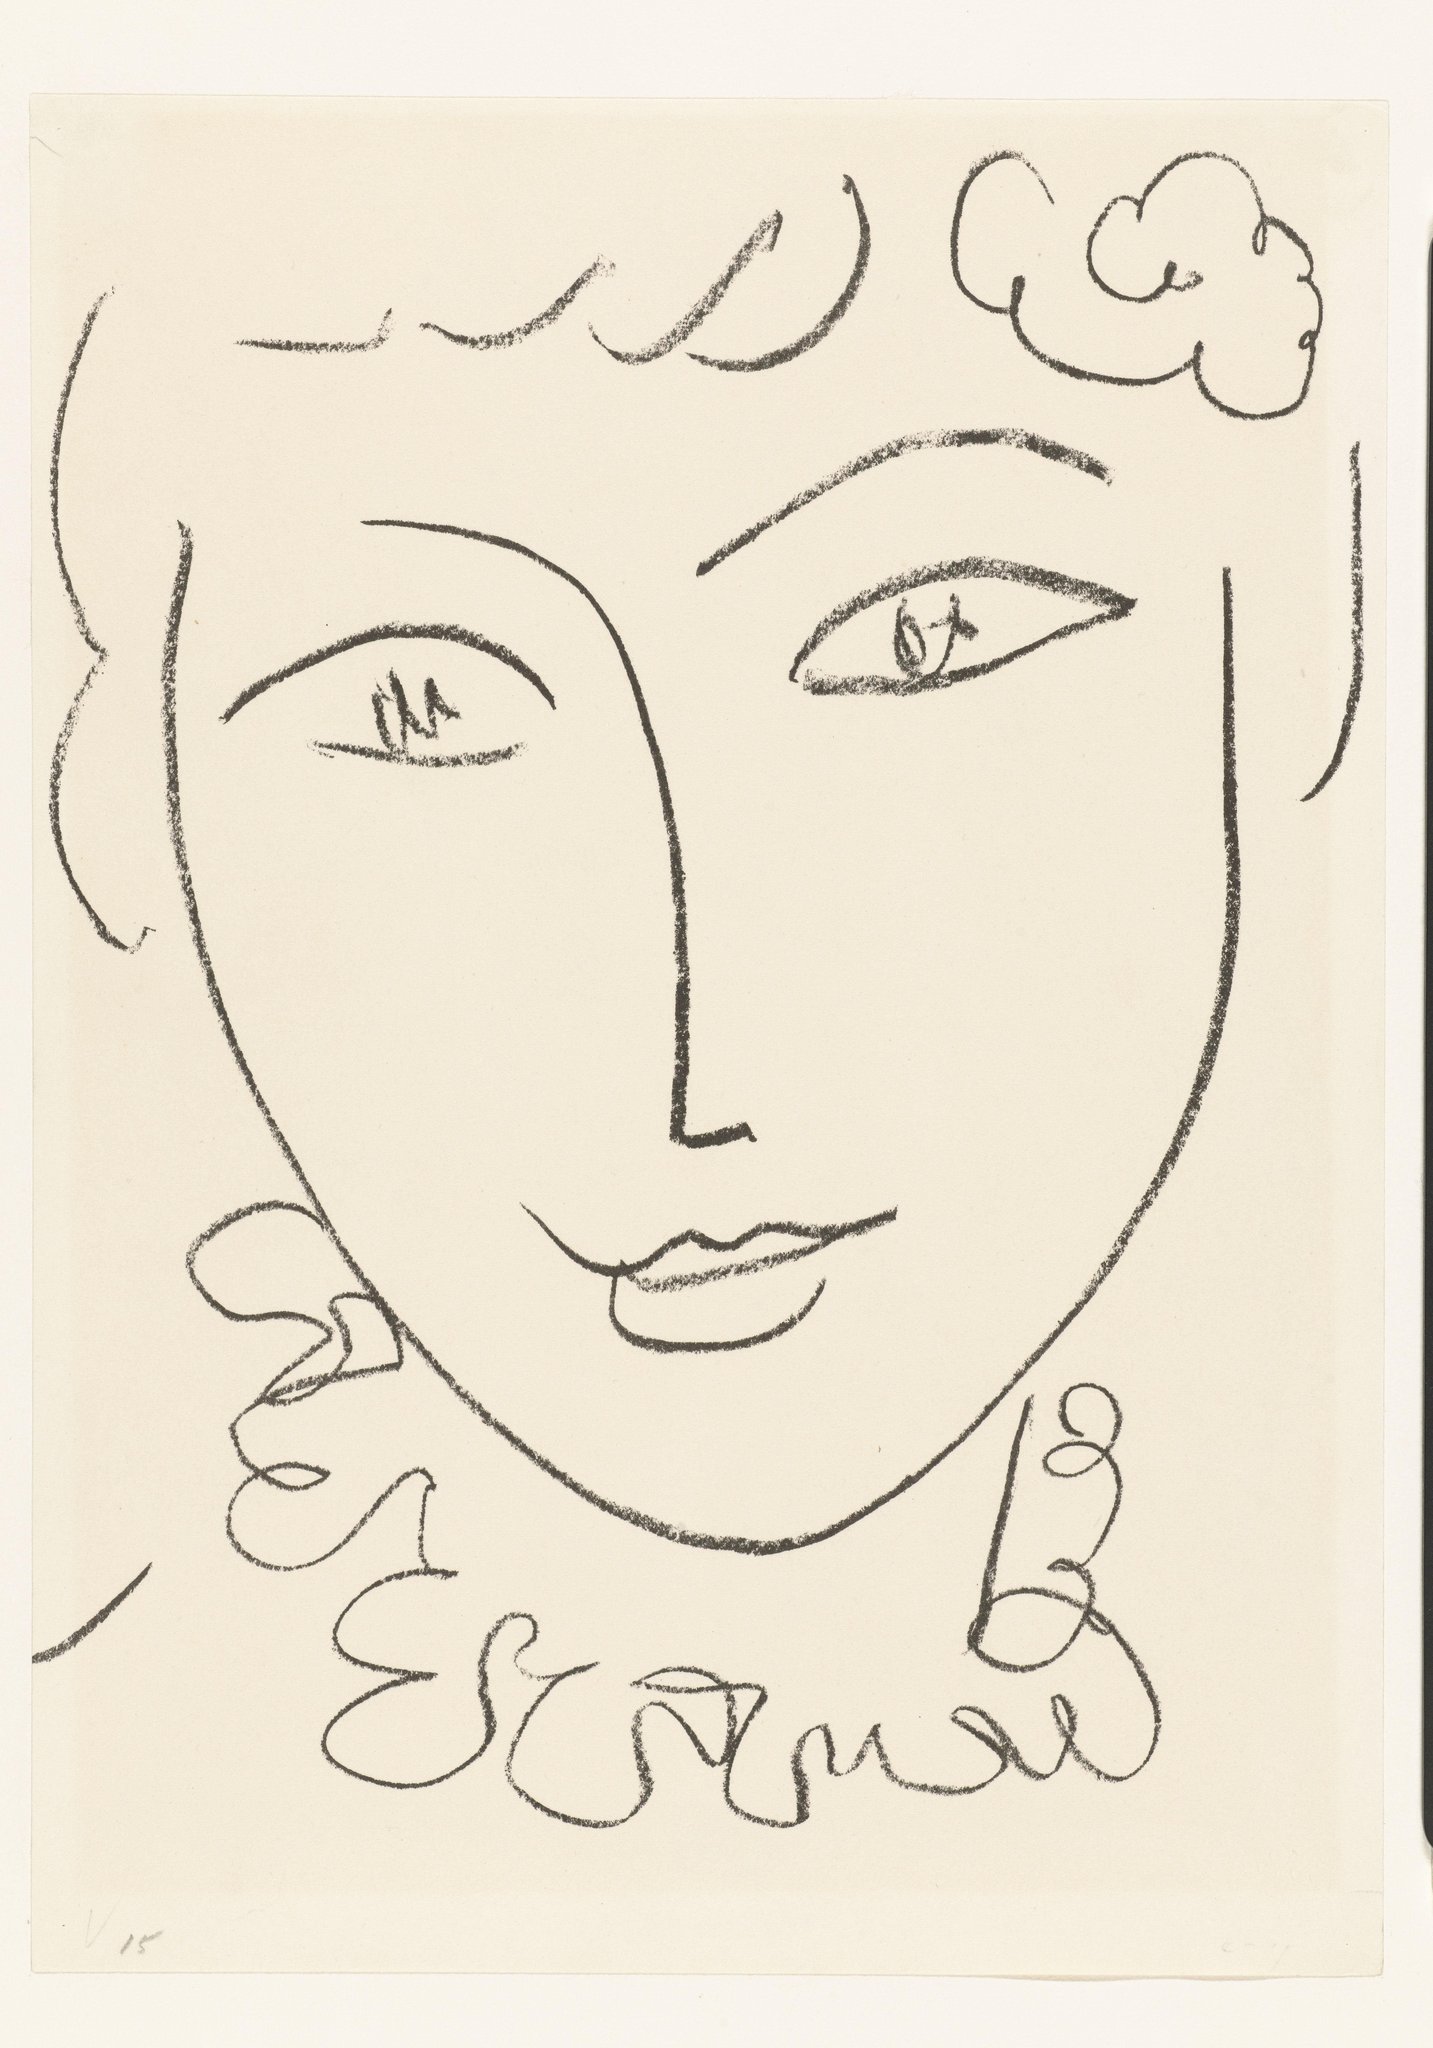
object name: book illustration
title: Portrait of a Woman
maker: henri matisse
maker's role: print maker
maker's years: 1869-1954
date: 1951-1954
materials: paper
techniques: lithograph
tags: head (human), female sex; woman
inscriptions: inscription: ‘sv 15/175’, initials: ‘HM’, edition: ‘1/15’, collector's mark: Lugt 2228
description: Matisse continued to be Bruna’s greatest source of inspiration from the 1950s. According to Bruna, ‘the most difficult thing is keeping it simple.’ Matisse rendered this woman’s bold expression with a minimum of means. The varying thickness of the lines lends the flat plane three-dimensionality. This sheet is the first page of a book with countless alluring faces.